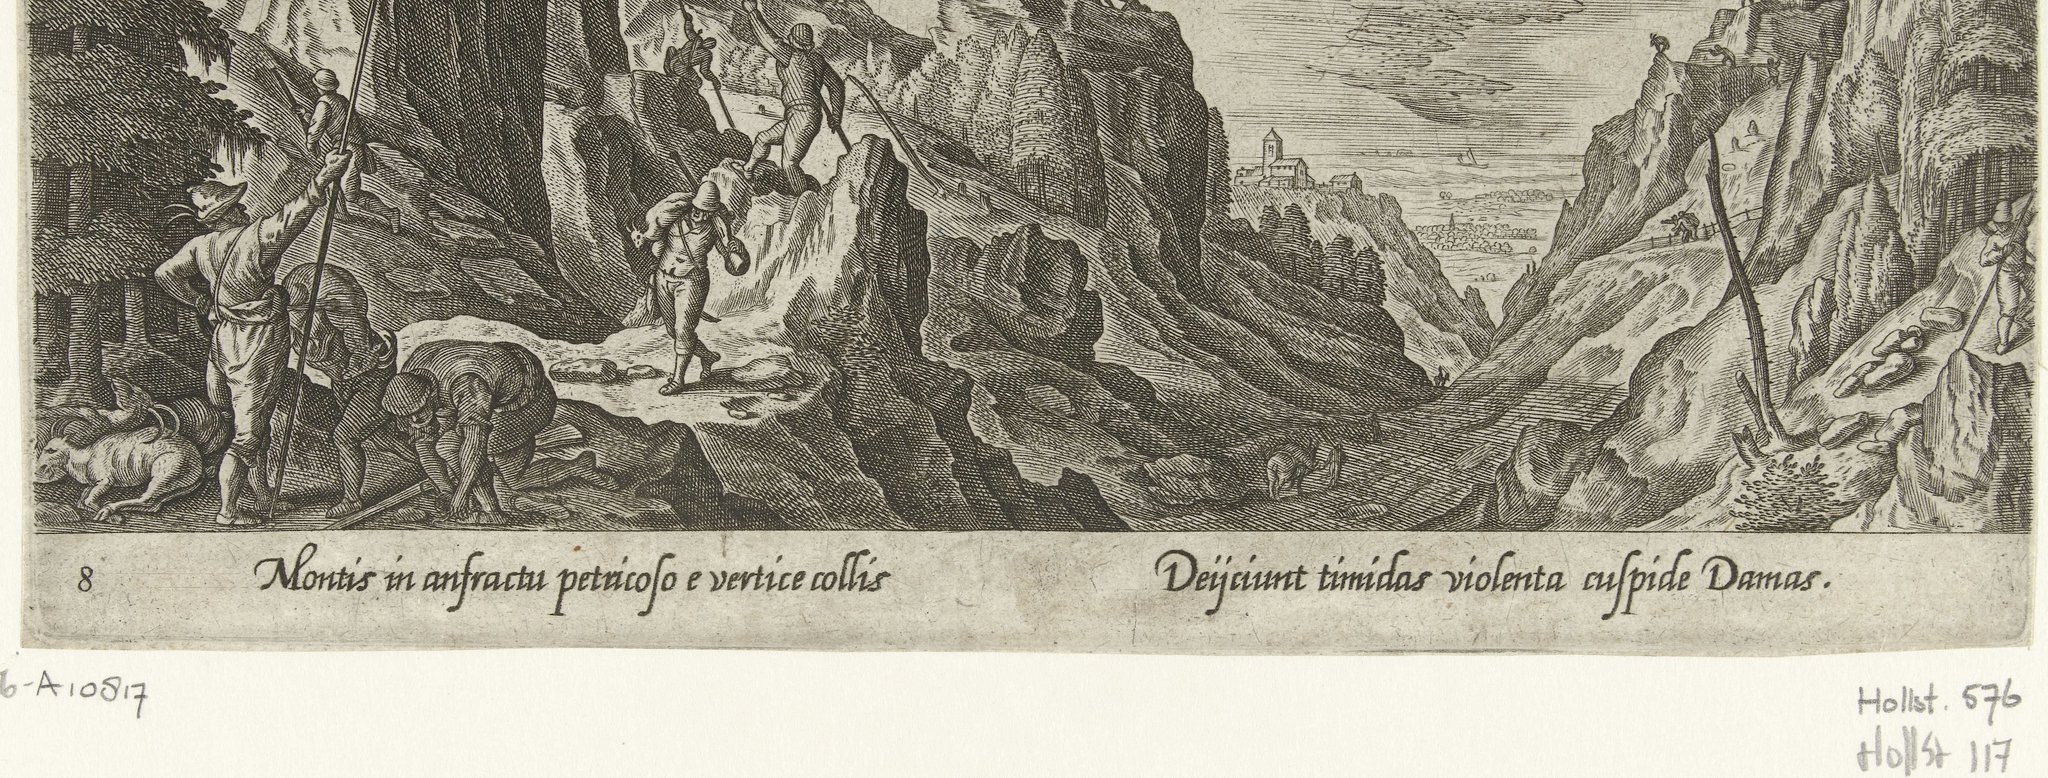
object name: print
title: Jacht en visvangst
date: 1582-1636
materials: paper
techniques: engraving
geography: antwerp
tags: hoofed animals: chamois, hunt ~ hoofed animals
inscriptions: collector's mark: Lugt 2228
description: Gemzen worden met speren opgejaagd. De prent heeft een Latijns onderschrift en maakt deel uit van een serie van 54 prenten.